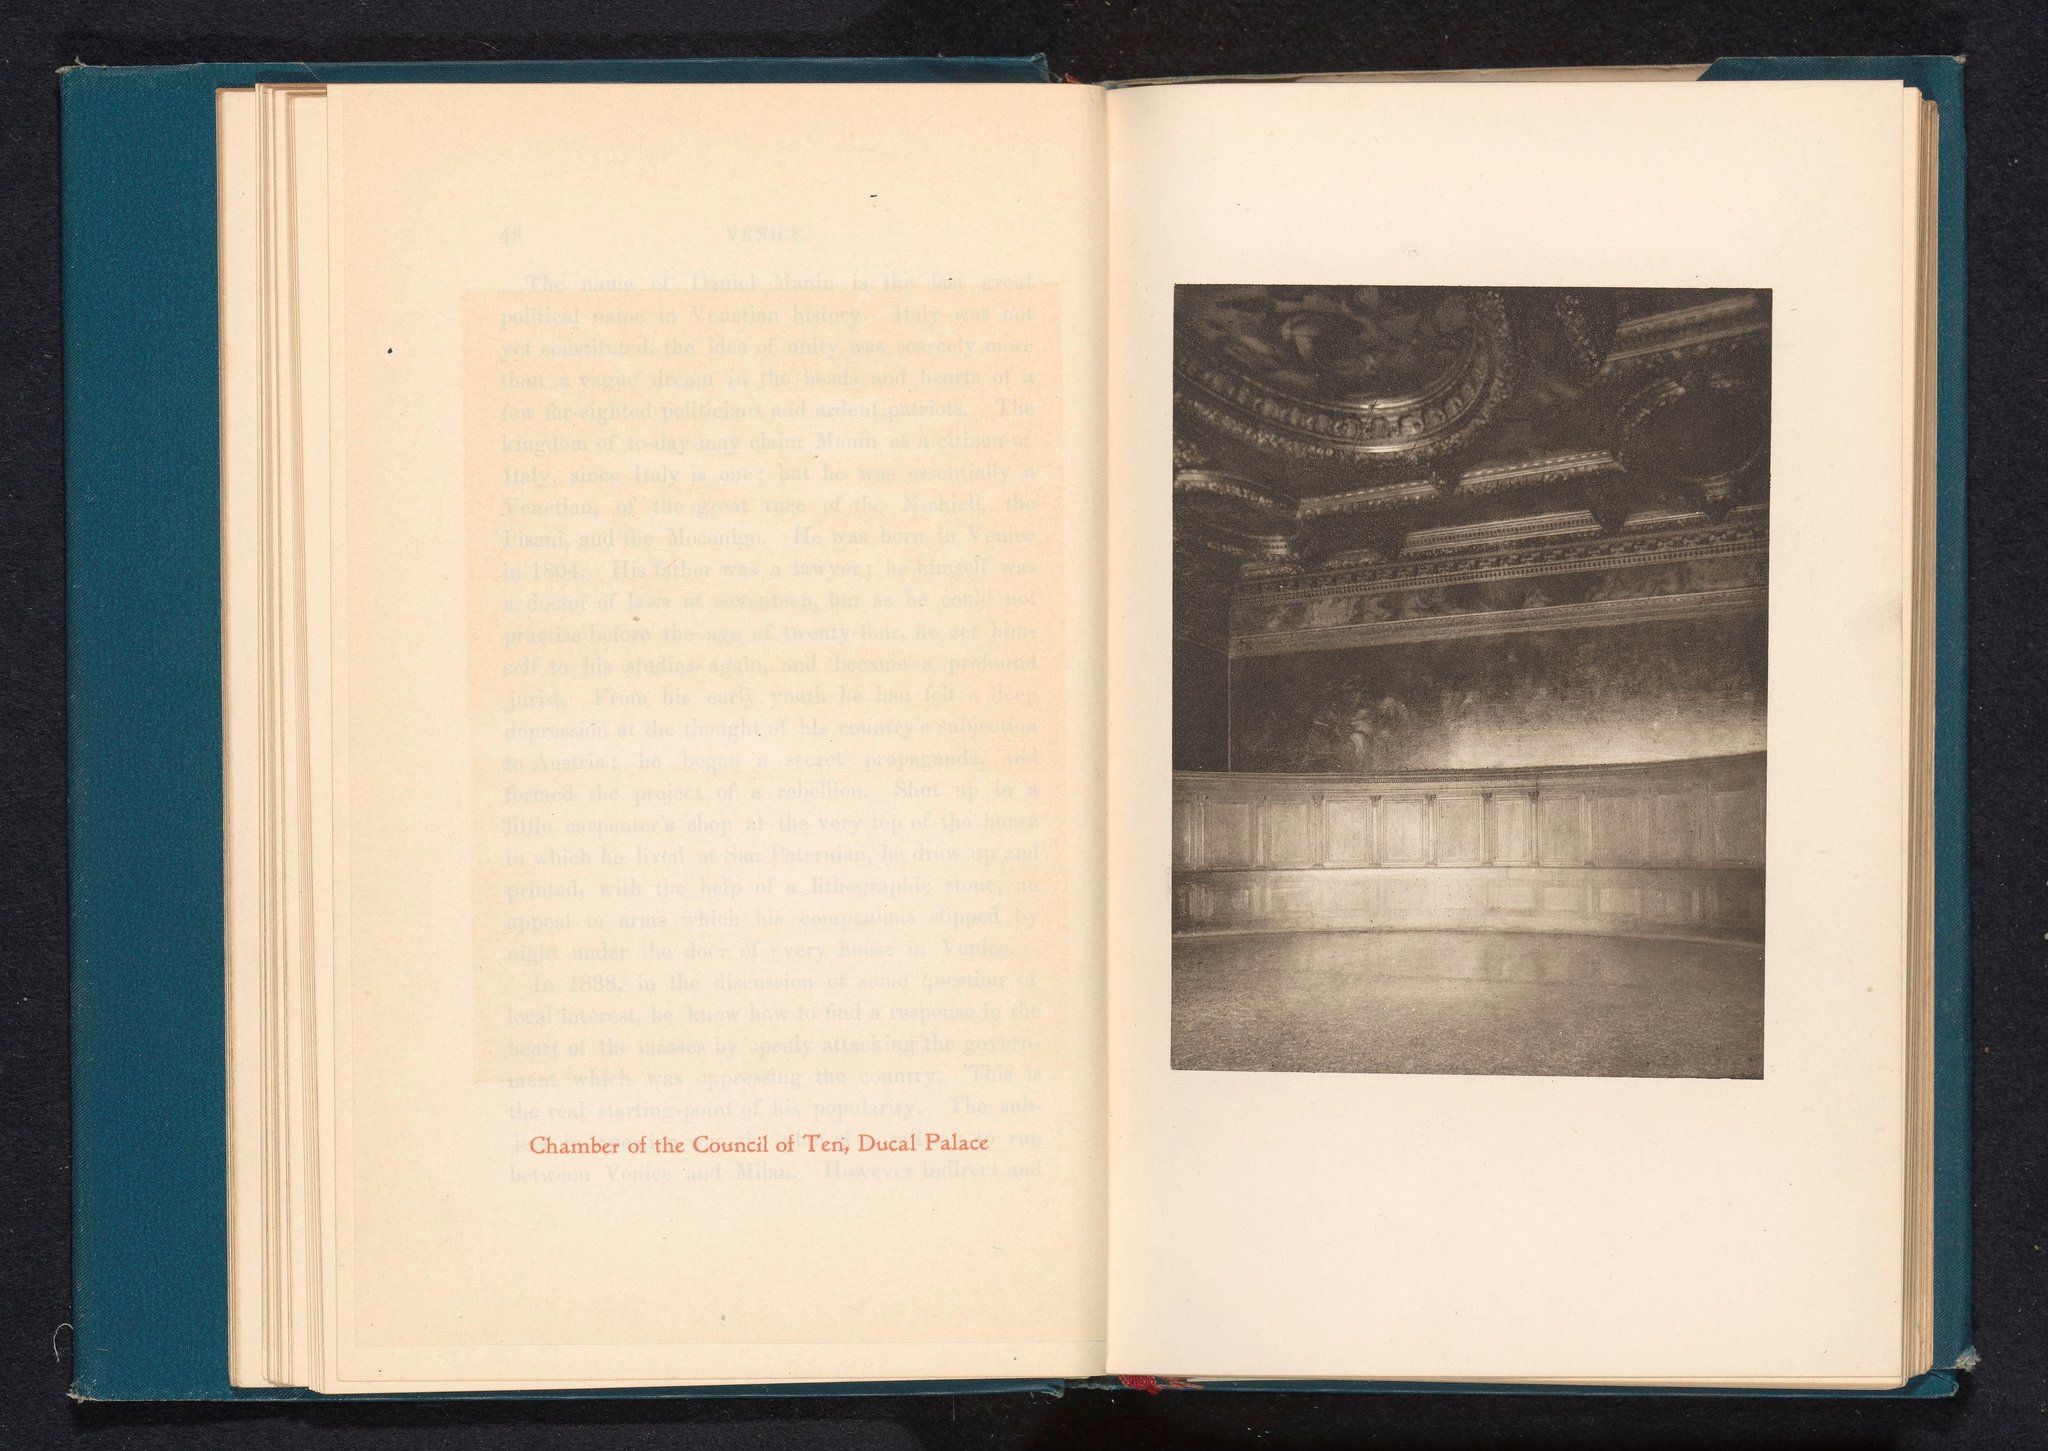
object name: page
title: Interieur van de kamer van de Raad van Tien in het Dogepaleis te Venetië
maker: Anonymous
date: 1882-1892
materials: paper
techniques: photoaquatint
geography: dogepaleis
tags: interior ~ representation of a building, façade (of house or building)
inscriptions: title: ‘Chamber of the Council of Ten, Ducal Palace’